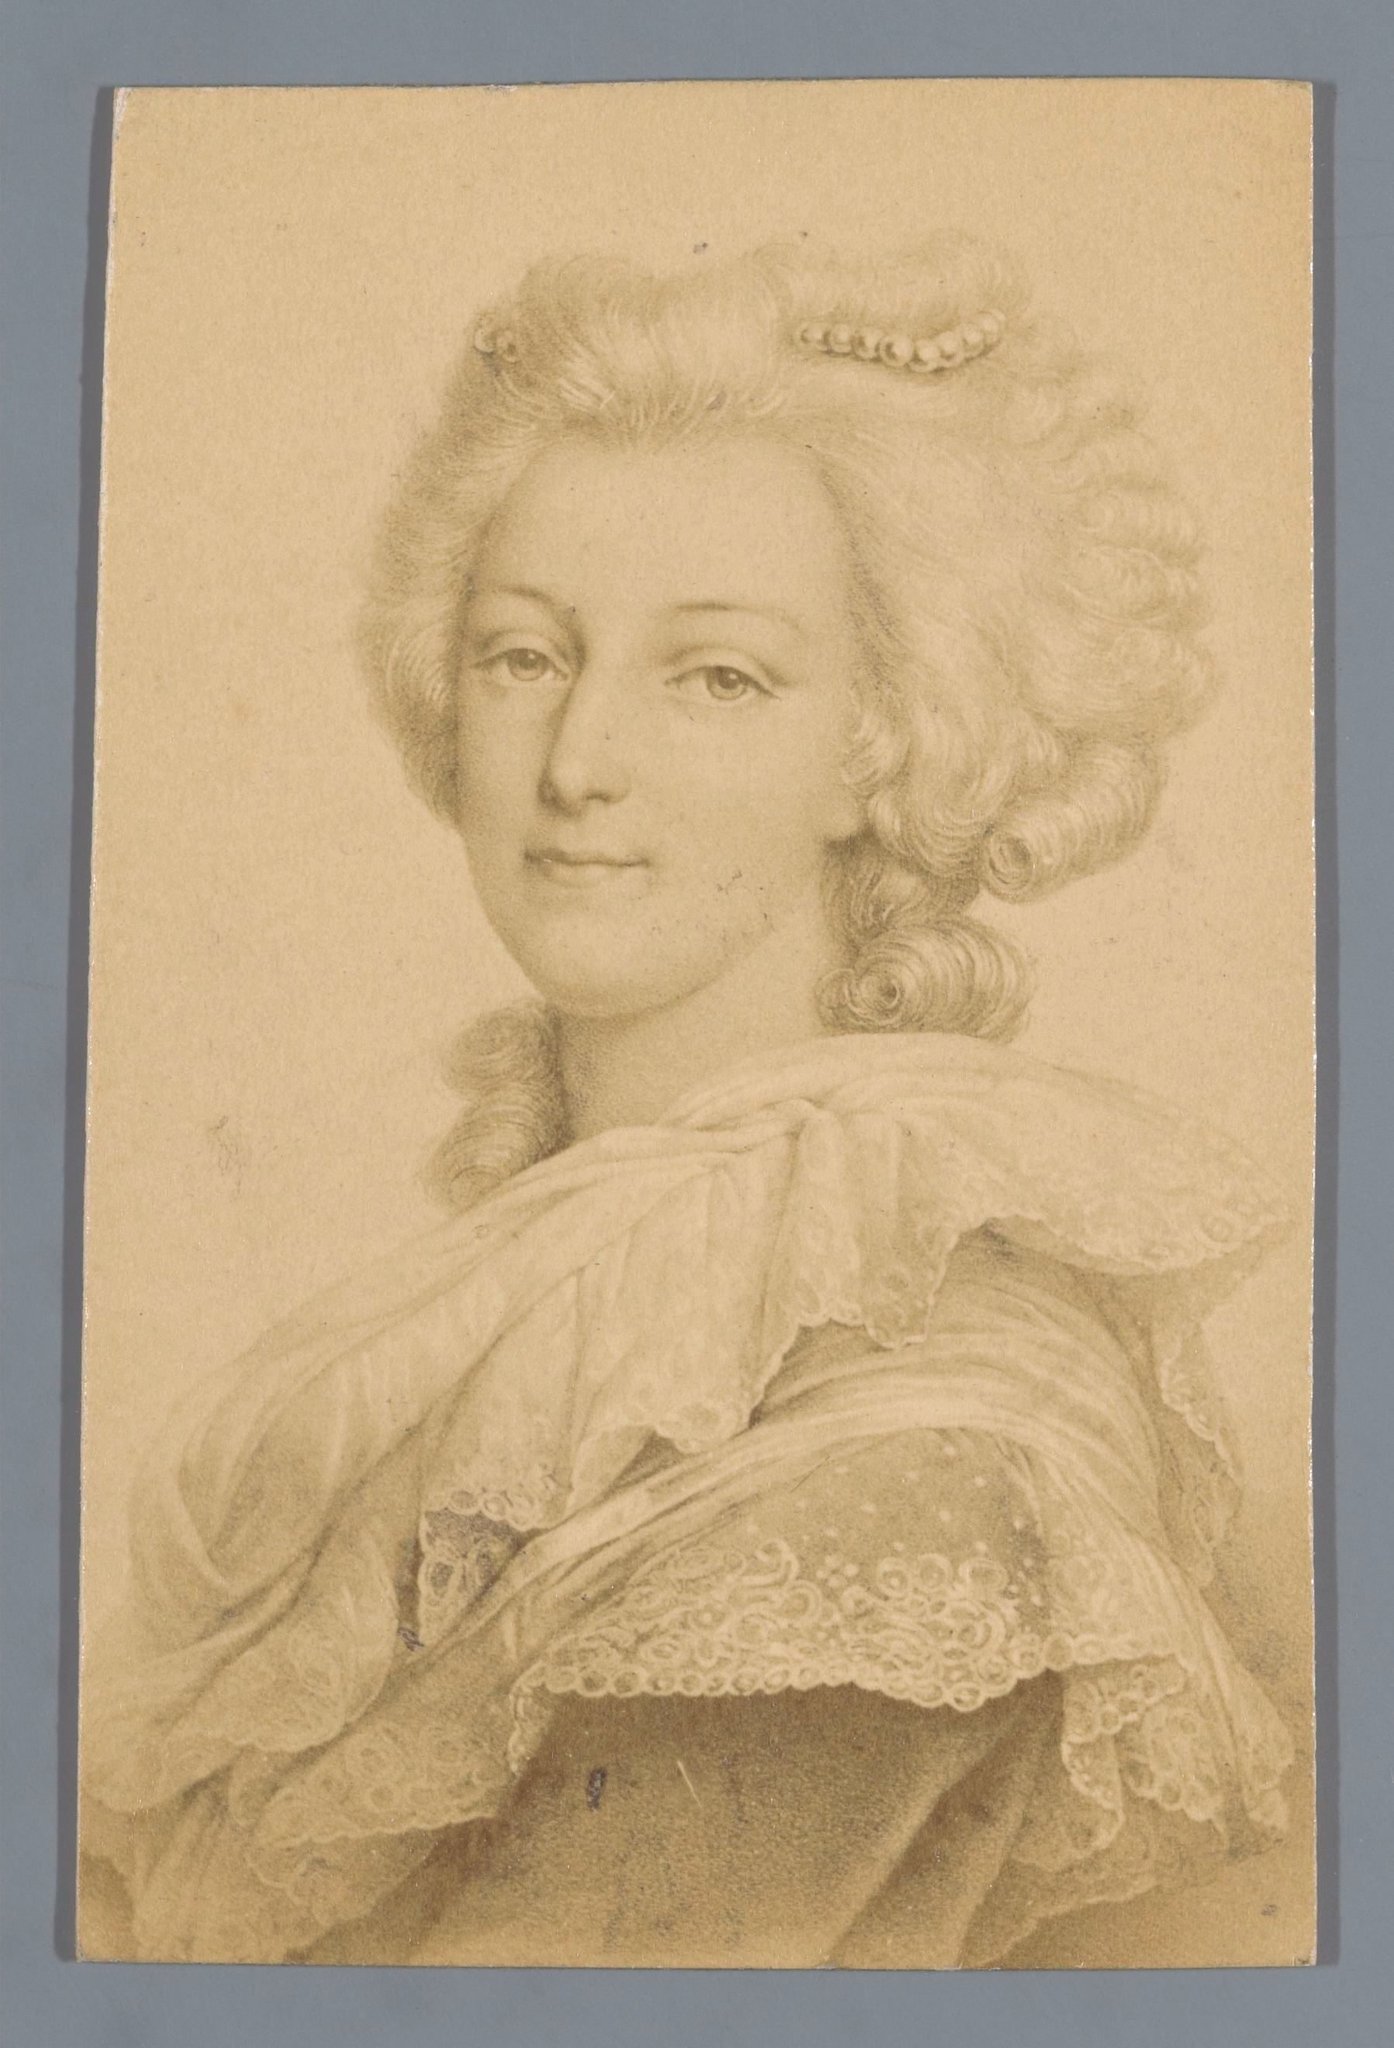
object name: reproduction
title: Fotoreproductie van een portret van een onbekende vrouw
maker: Anonymous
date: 1860-1900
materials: cardboard, photographic support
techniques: albumen print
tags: adult woman, anonymous historical person portrayed